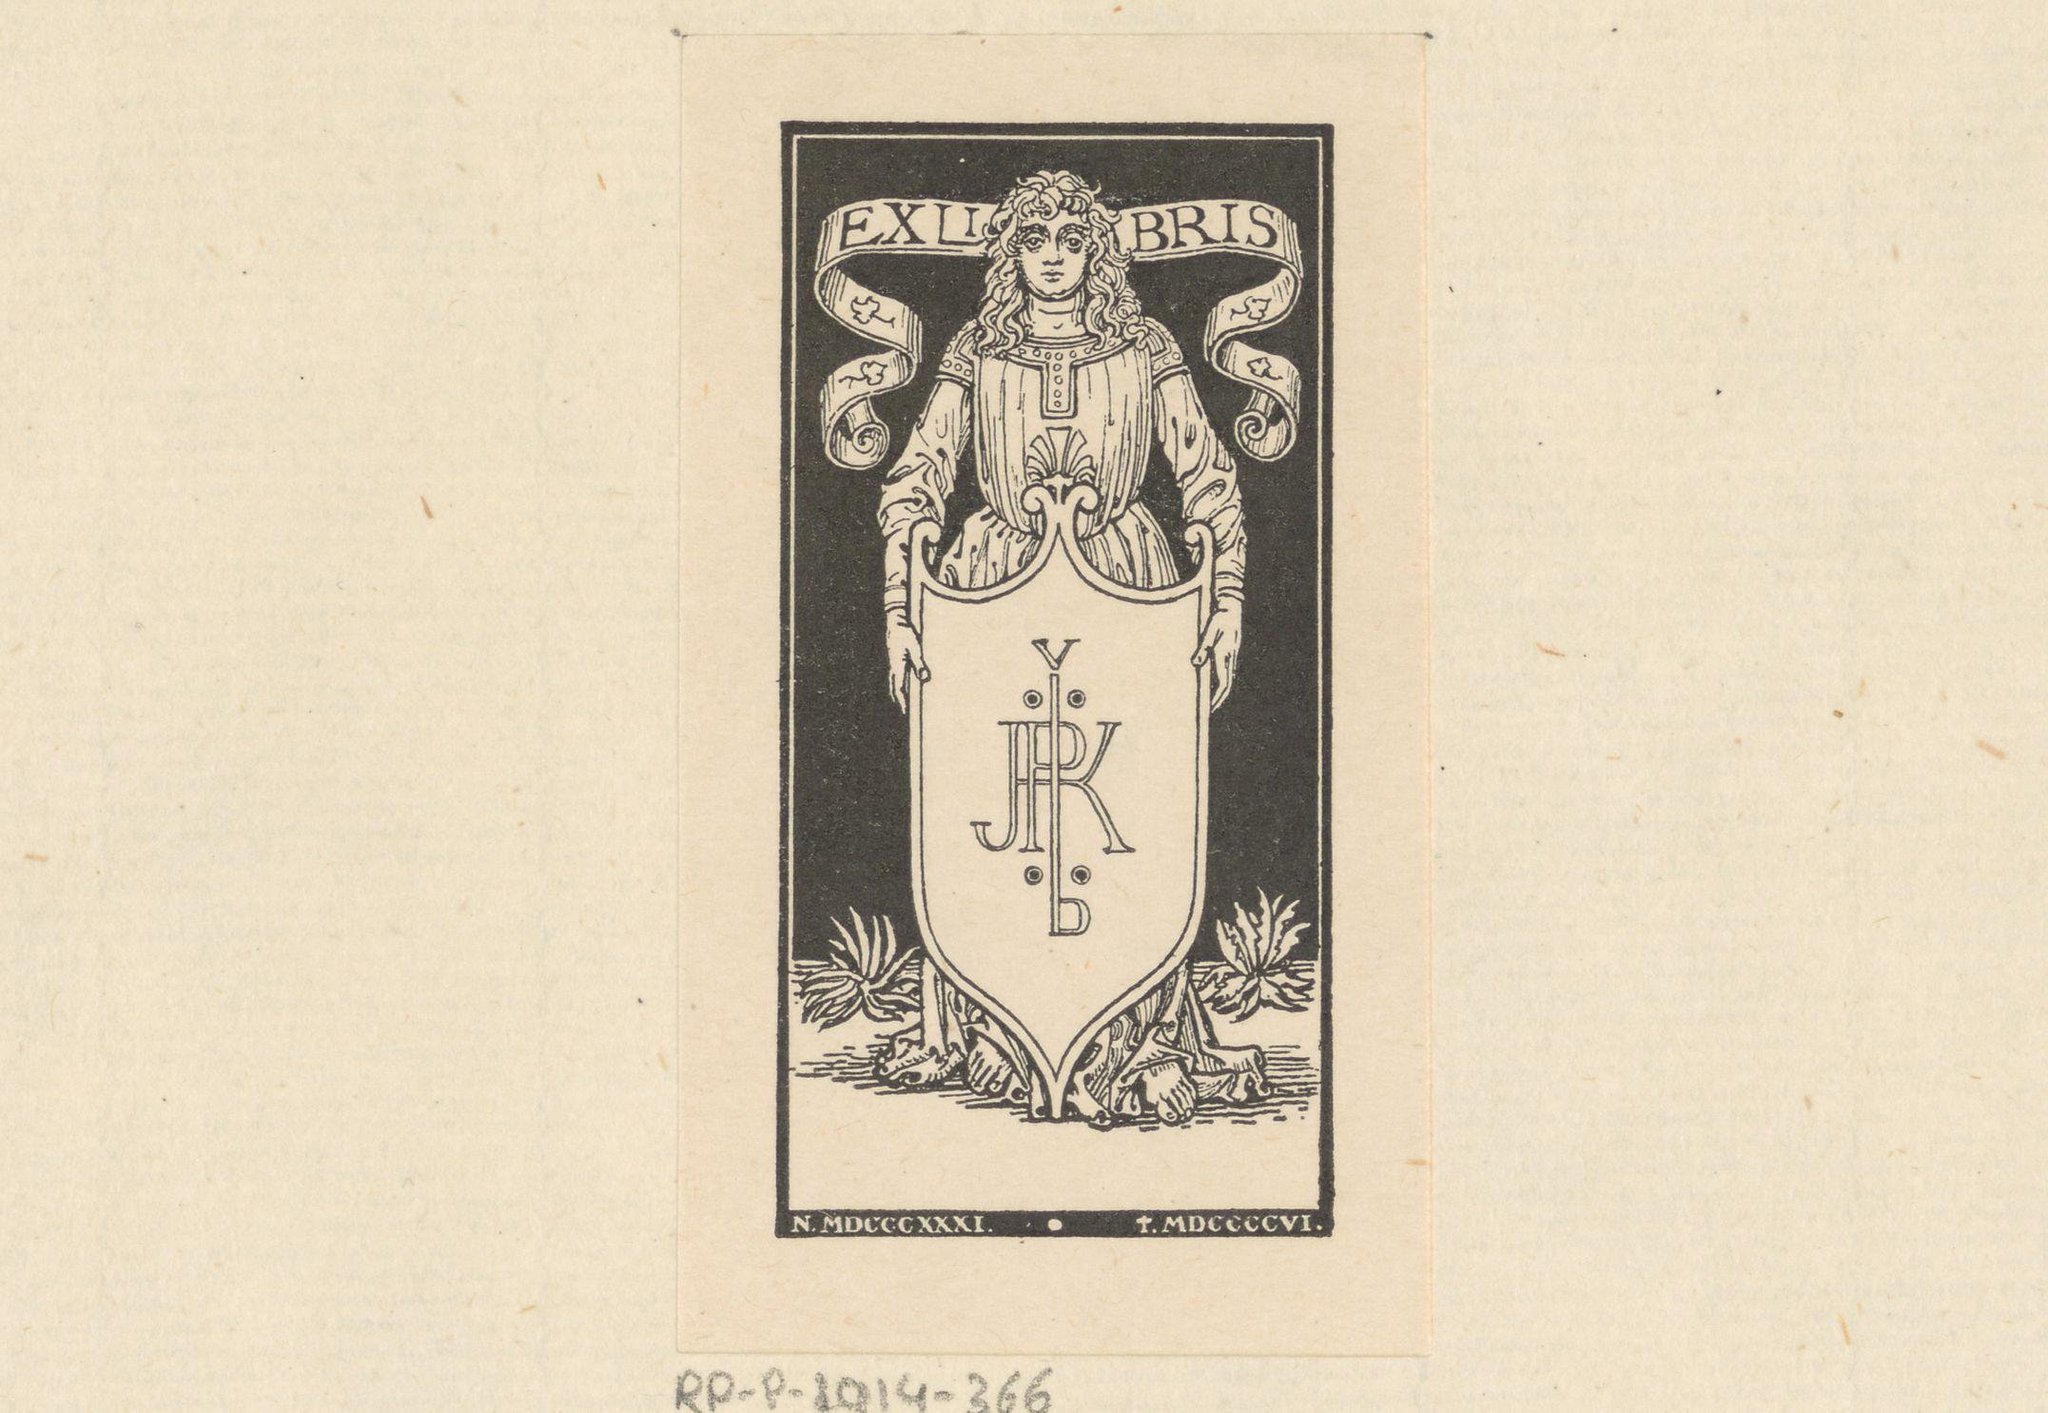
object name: bookplate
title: Ex libris van J.Ph. van der Kellen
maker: Anonymous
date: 1850-1906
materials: paper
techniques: printing block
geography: netherlands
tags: utrecht, print maker, draughtsman, johan philip van der kellen, shield-bearer, squire, youth, adolescent, historical costume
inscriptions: collector's mark: Lugt 2233